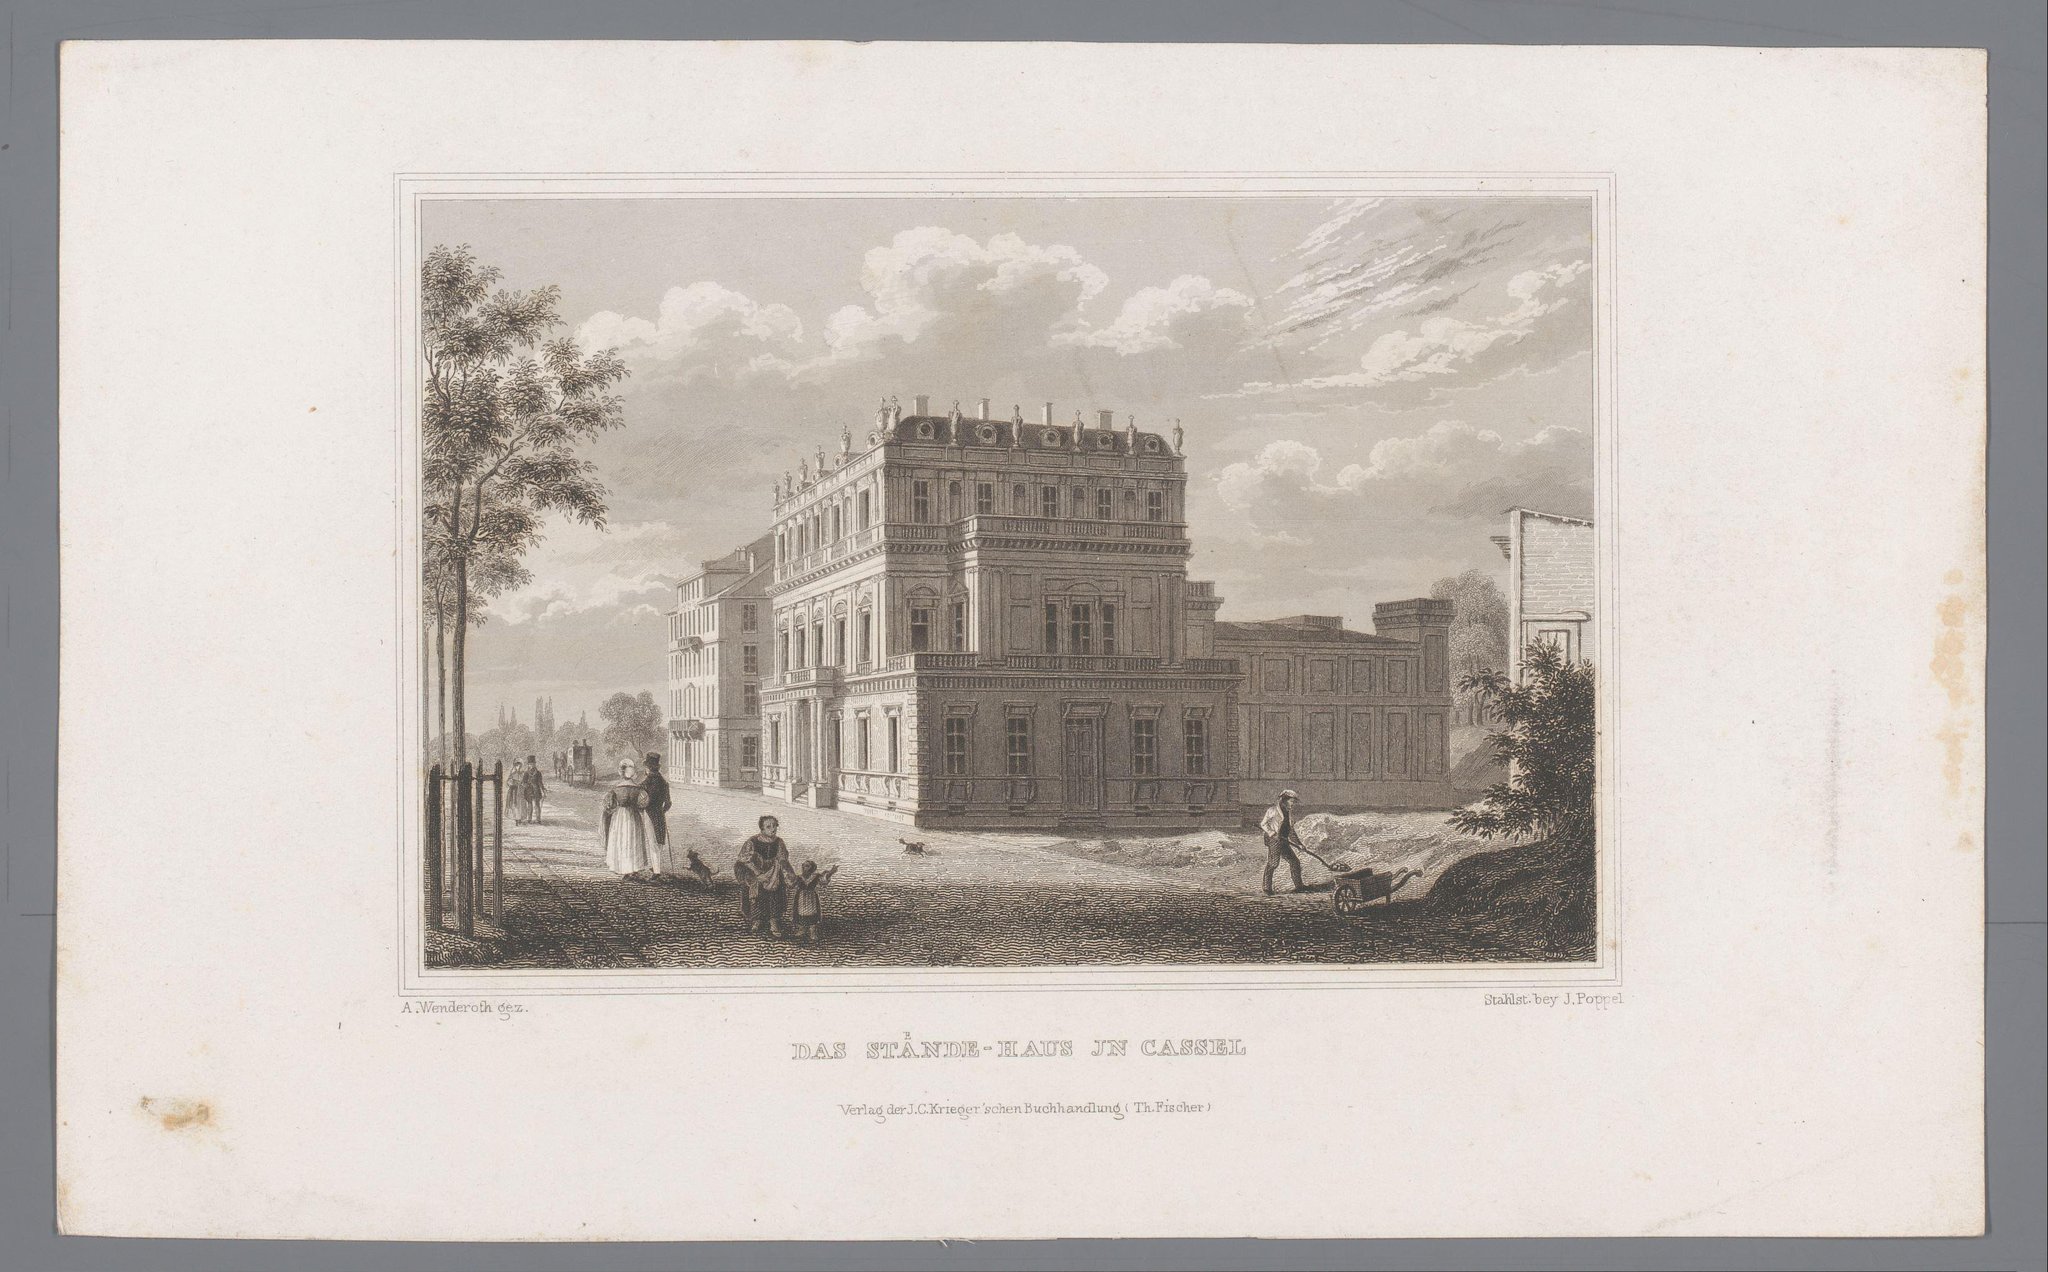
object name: print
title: Das St:ande-Haus in Cassel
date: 1858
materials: paper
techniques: engraving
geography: kassel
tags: city-view, and landscape with man-made constructions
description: Prent ook gebruikt in: Lange, Gustav Georg. Kurfürstenthum Hessen in malerischen Original Ansichten. Darmstadt: Krieger, 1858.